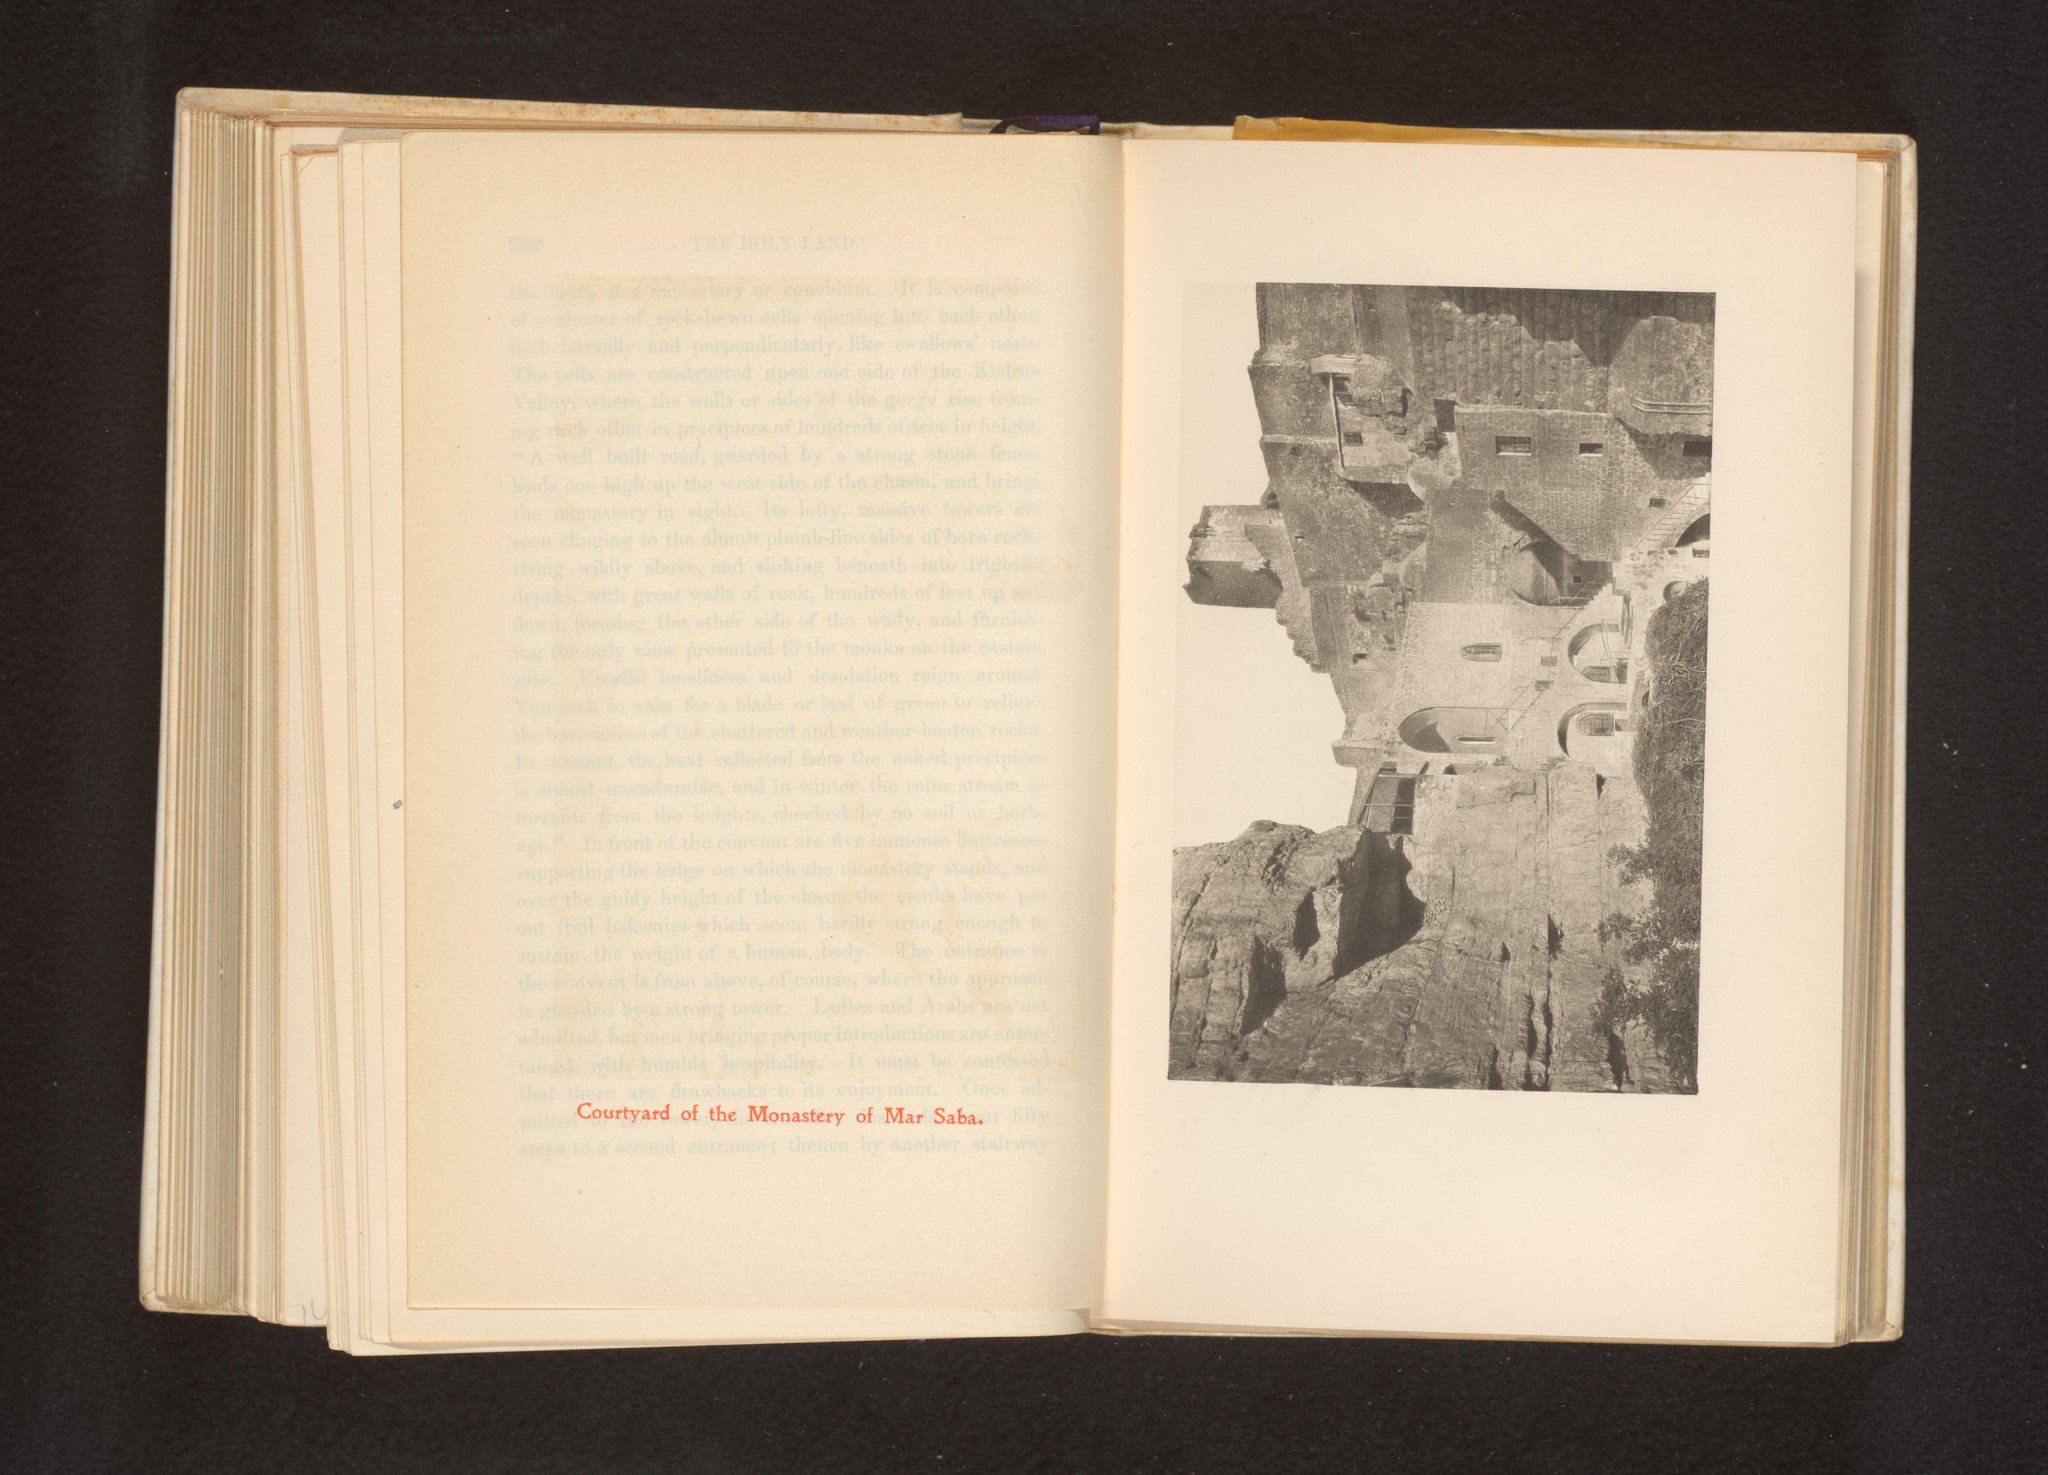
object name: photomechanical print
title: Binnenhof van het klooster van Mar Saba in de Kidronvallei te Palestina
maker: Anonymous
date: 1890-1900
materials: paper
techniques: photoaquatint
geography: kidron valley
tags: abbey, monastery, convent ~ roman catholic church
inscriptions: title: ‘Courtyard of the Monastery of Mar Saba.’